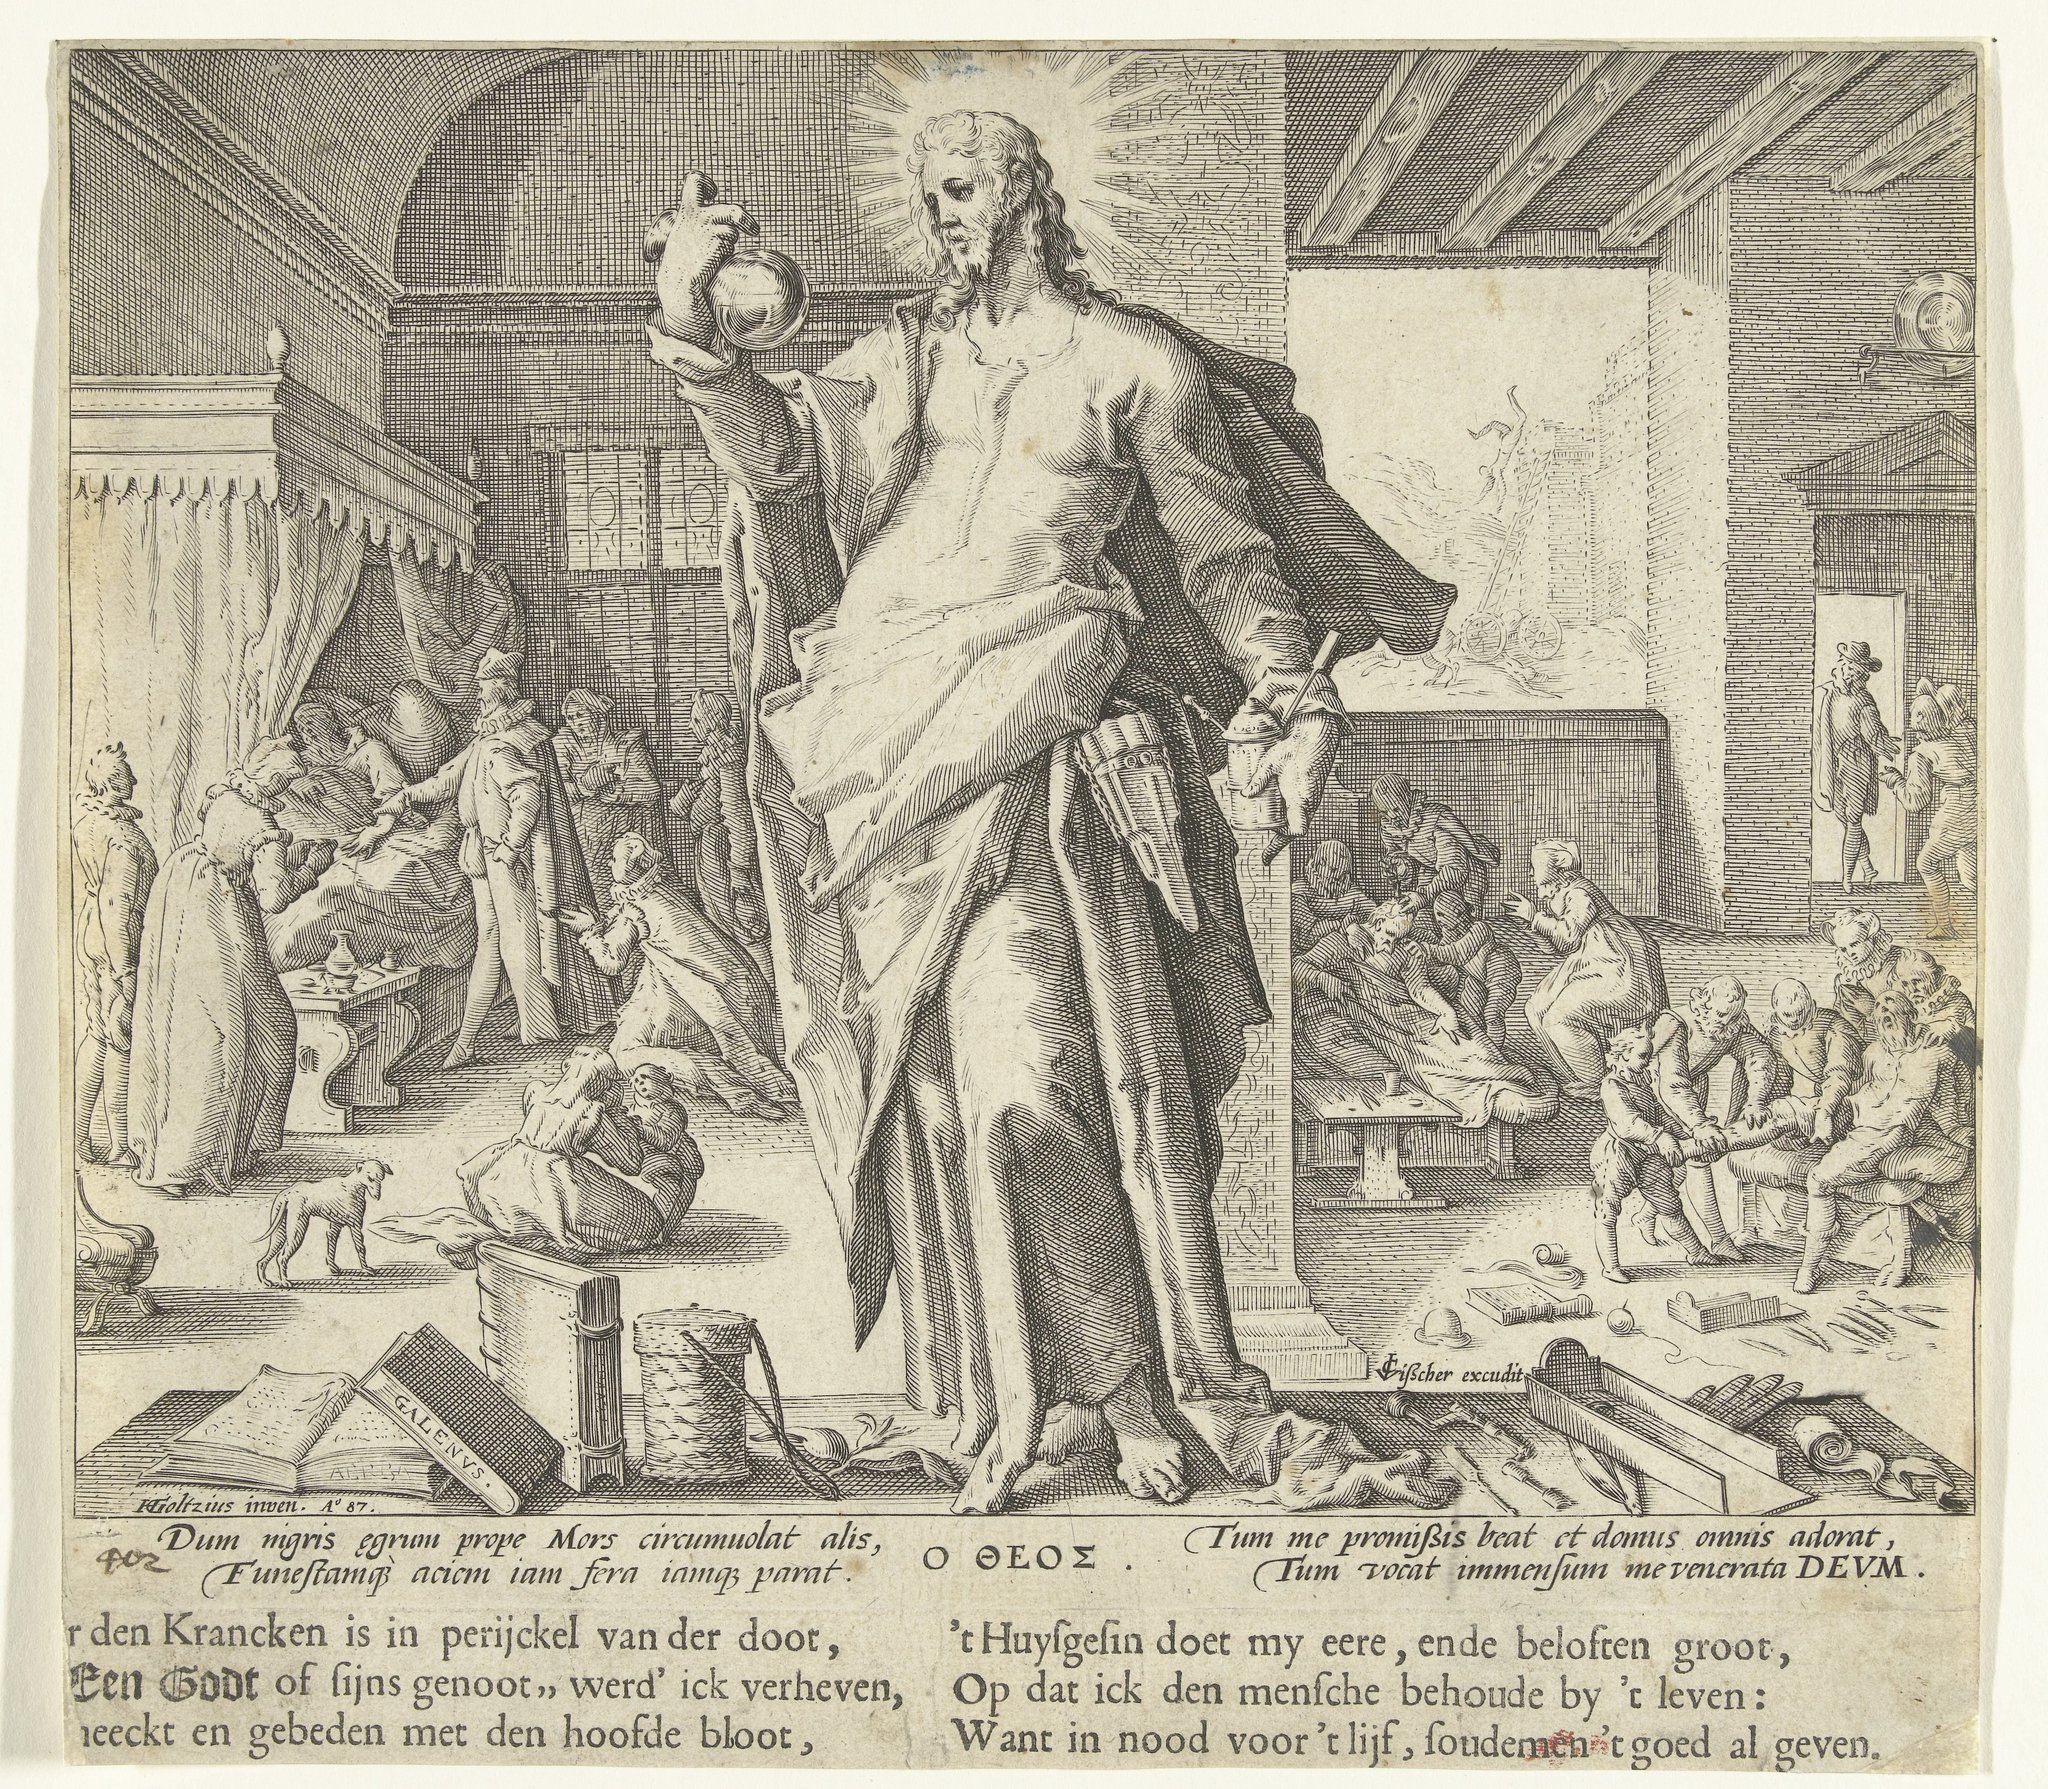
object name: print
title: Het medische beroep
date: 1587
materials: paper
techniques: engraving, letterpress printing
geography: haarlem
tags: christ as physician, bed with tester, sick-bed, urinal (and basket), physician, doctor, examination of urine, falling, operation, surgery, feeling pulse or heart-beat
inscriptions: collector's mark: Lugt 2228a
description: In een huis ligt een man ziek in bed, familieleden onthutst en biddend om hem heen. Een arts voelt zijn pols. In het vertrek daar rechts naast en door het raam is te zien wat er gebeurd is met de man: hij heeft zijn hoofd en been bezeerd bij een val van een ladder. Op de voorgrond een Christusachtige figuur, staand te midden van medische handboeken en instrumenten. Onder de voorstelling gegraveerde Latijnse en Griekse teksten en (buiten de plaatrand maar op hetzelfde blad) een gedrukte Nederlandse tekst, waarin wordt uitgelegd dat de arts als een god wordt binnengehaald als iemands leven aan een zijden draadje hangt. Deze prent is onderdeel van een serie van vier prenten waarop verbeeld is hoe de arts beschouwd en gewaardeerd wordt tijdens zijn bezoek aan een zieke: bij binnenkomst als een god, na de eerste hulp als een engel, bij genezing als een mens en wanneer er betaald moet worden als een duivel.